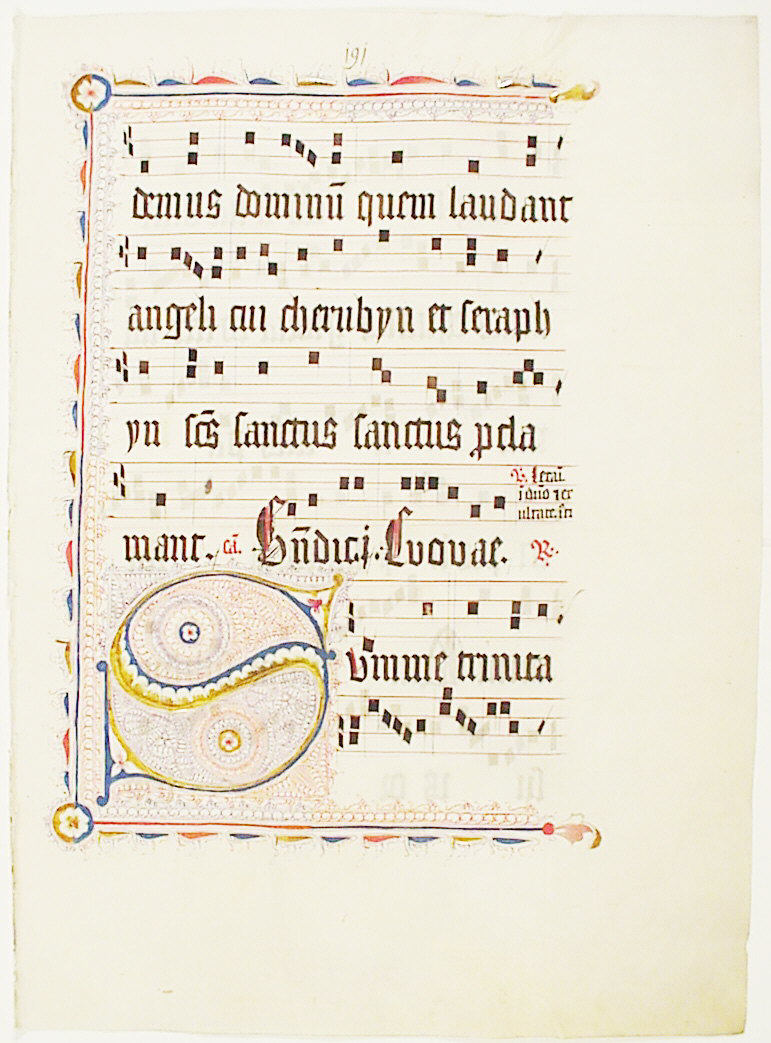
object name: antiphonary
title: Manuscript Leaf with Initial S, from an Antiphonary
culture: german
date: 1426-1450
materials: ink, metal leaf, parchment, paint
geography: germany